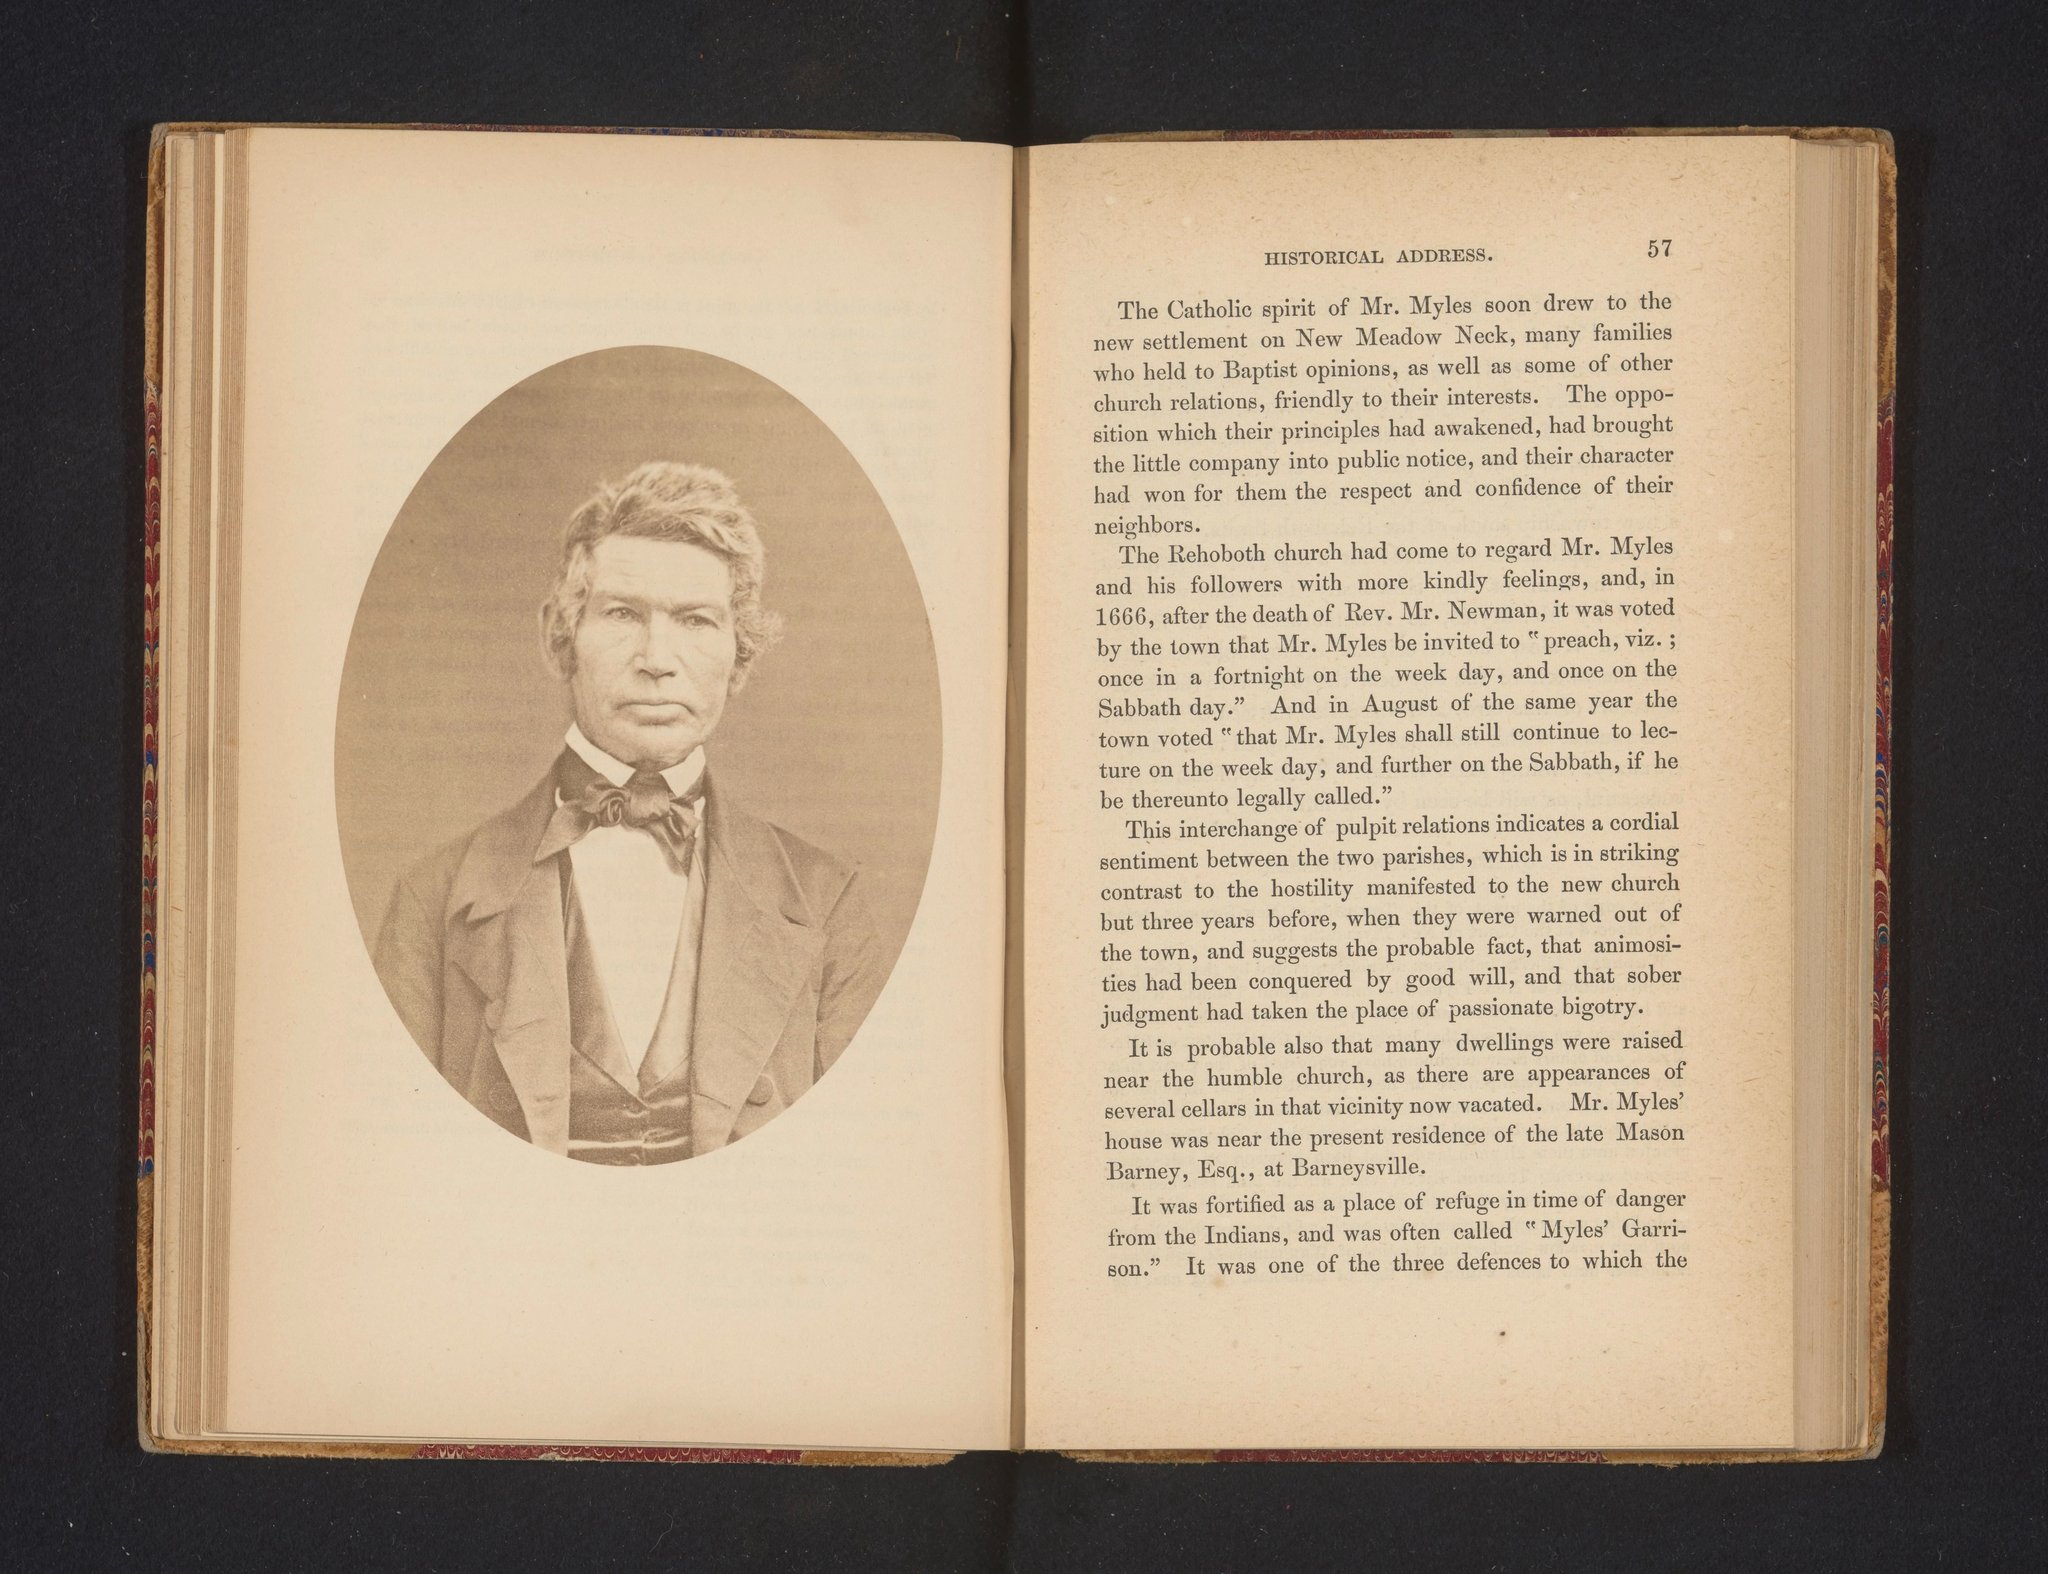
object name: photograph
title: Portret van Emerson Humphrey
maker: Anonymous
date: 1865-1870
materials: photographic support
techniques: salted paper print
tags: historical persons